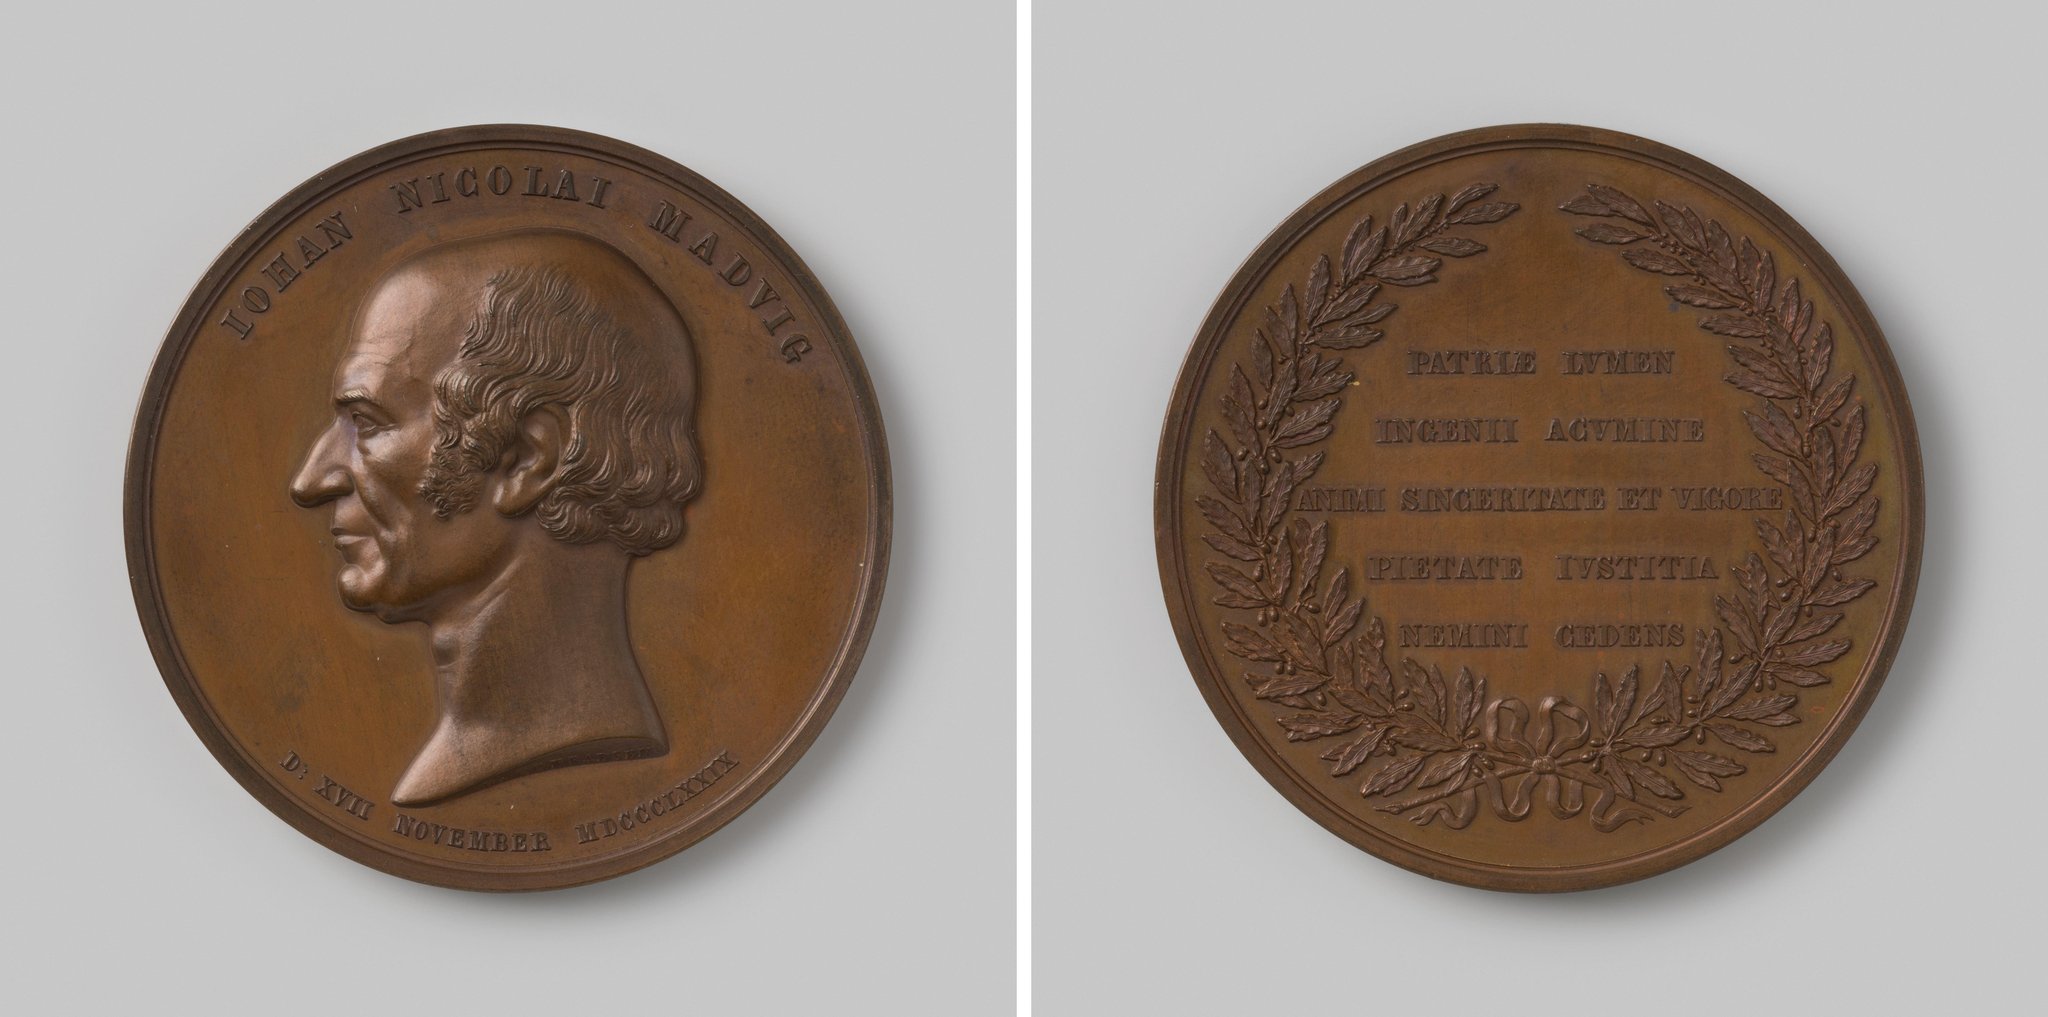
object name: history medal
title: Iohan Nicolai Madvig professor in de filosofie te Kopenhagen 1879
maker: harald conradsen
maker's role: sculptor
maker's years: 1817-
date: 1879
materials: bronze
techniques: striking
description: Bronzen penning, op de voorzijde het portret van Madvig naar links met boven en onder omschrift, op de keerzijde vijf regels tekst tussen twee samengestrikte lauwertakken.